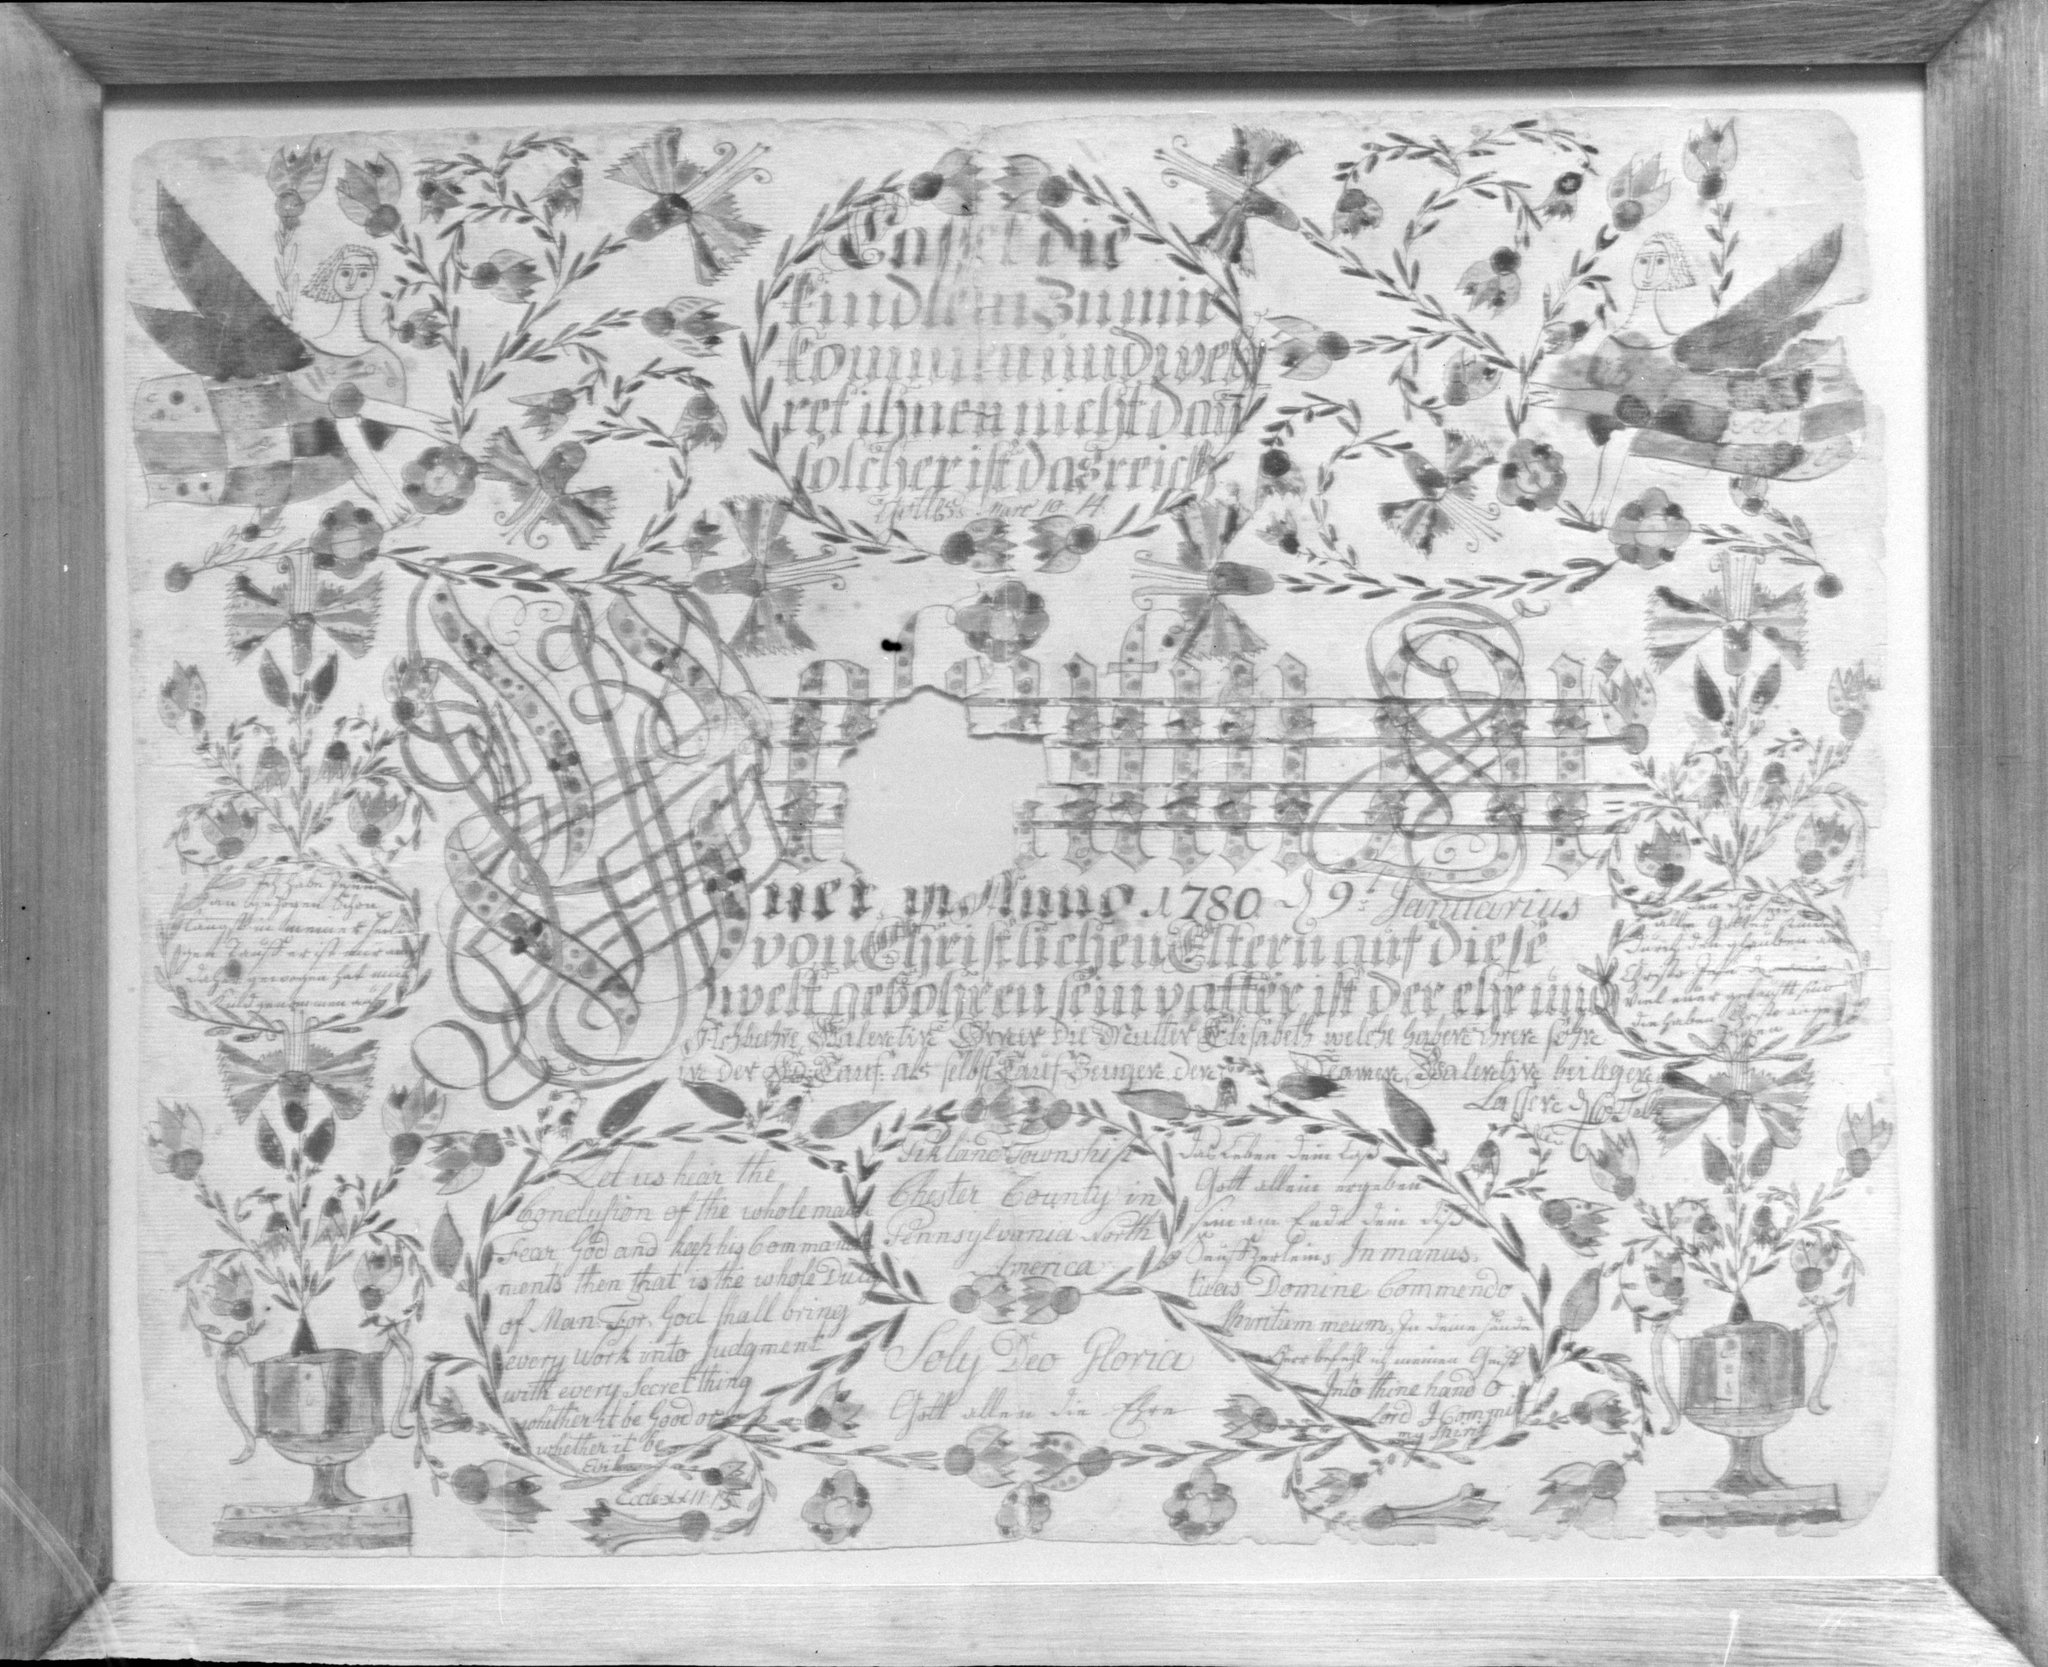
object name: birth and baptismal certificate, fraktur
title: Birth and Baptismal Certificate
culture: american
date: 1780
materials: ink, paper, watercolor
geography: united states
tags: flowers